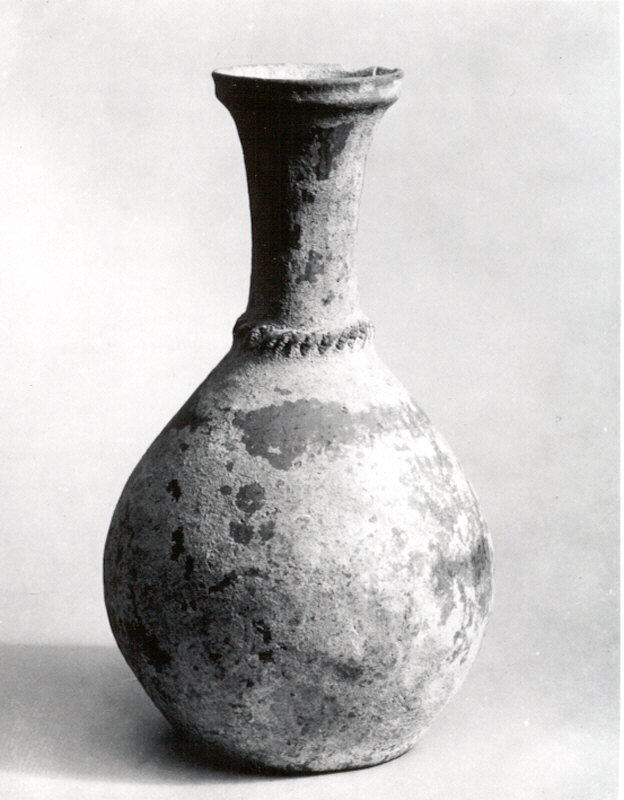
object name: vessel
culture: iranian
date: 1000-1 BCE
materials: ceramic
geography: northwestern iran